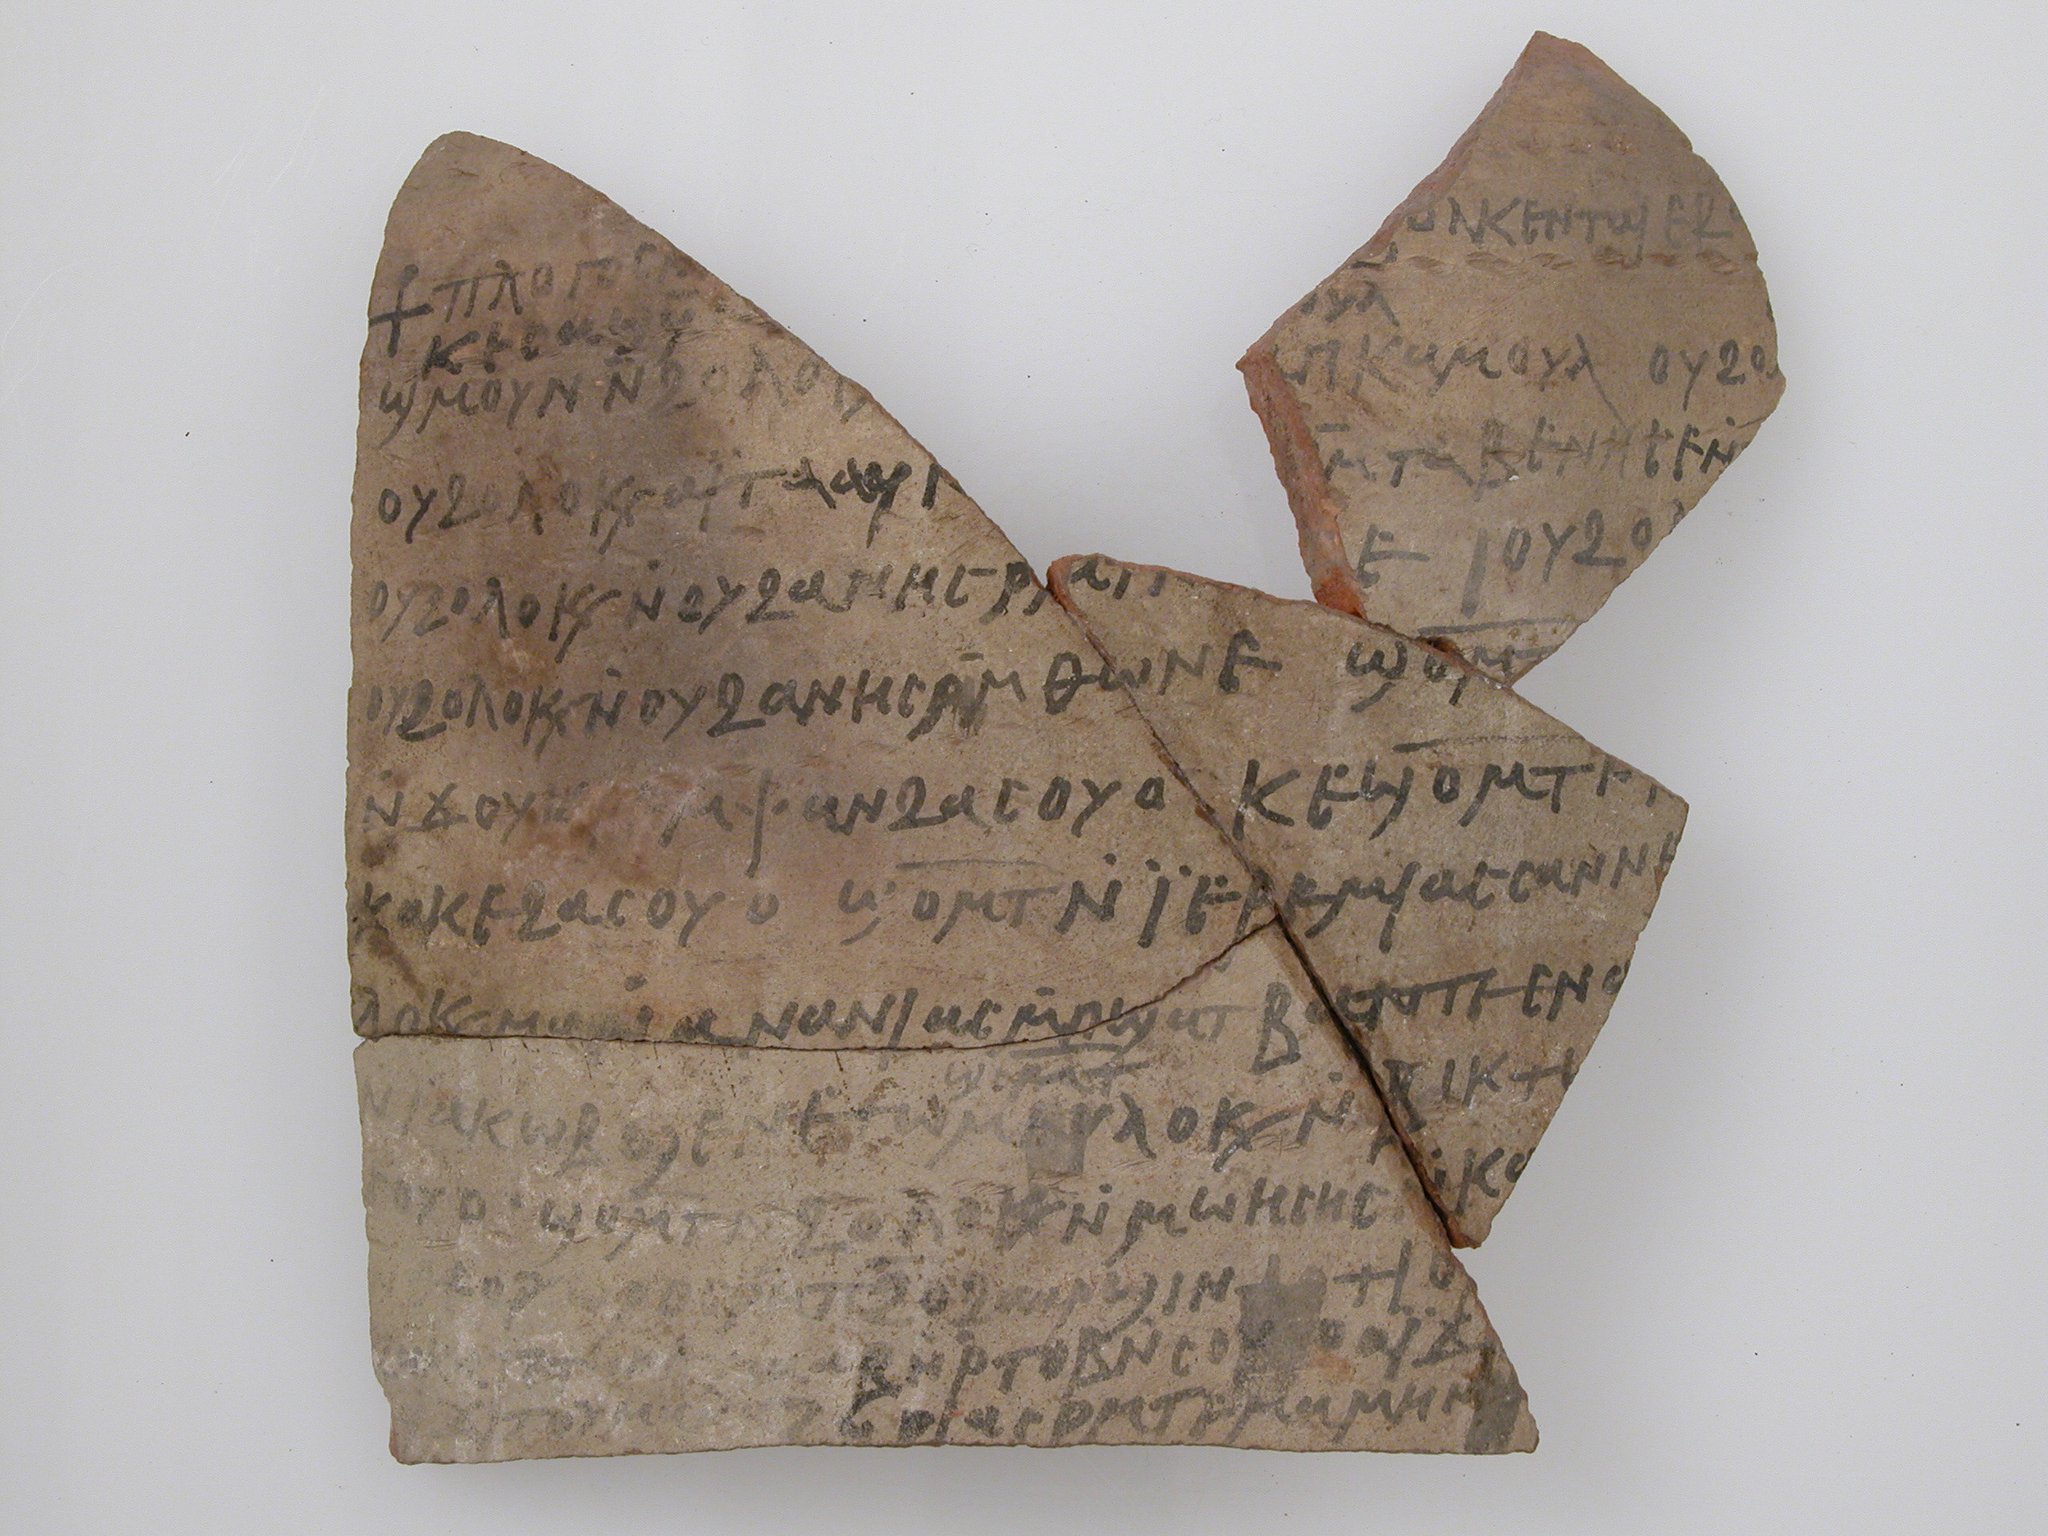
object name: ostrakon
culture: coptic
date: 601-700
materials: ink, pottery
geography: egypt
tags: documents